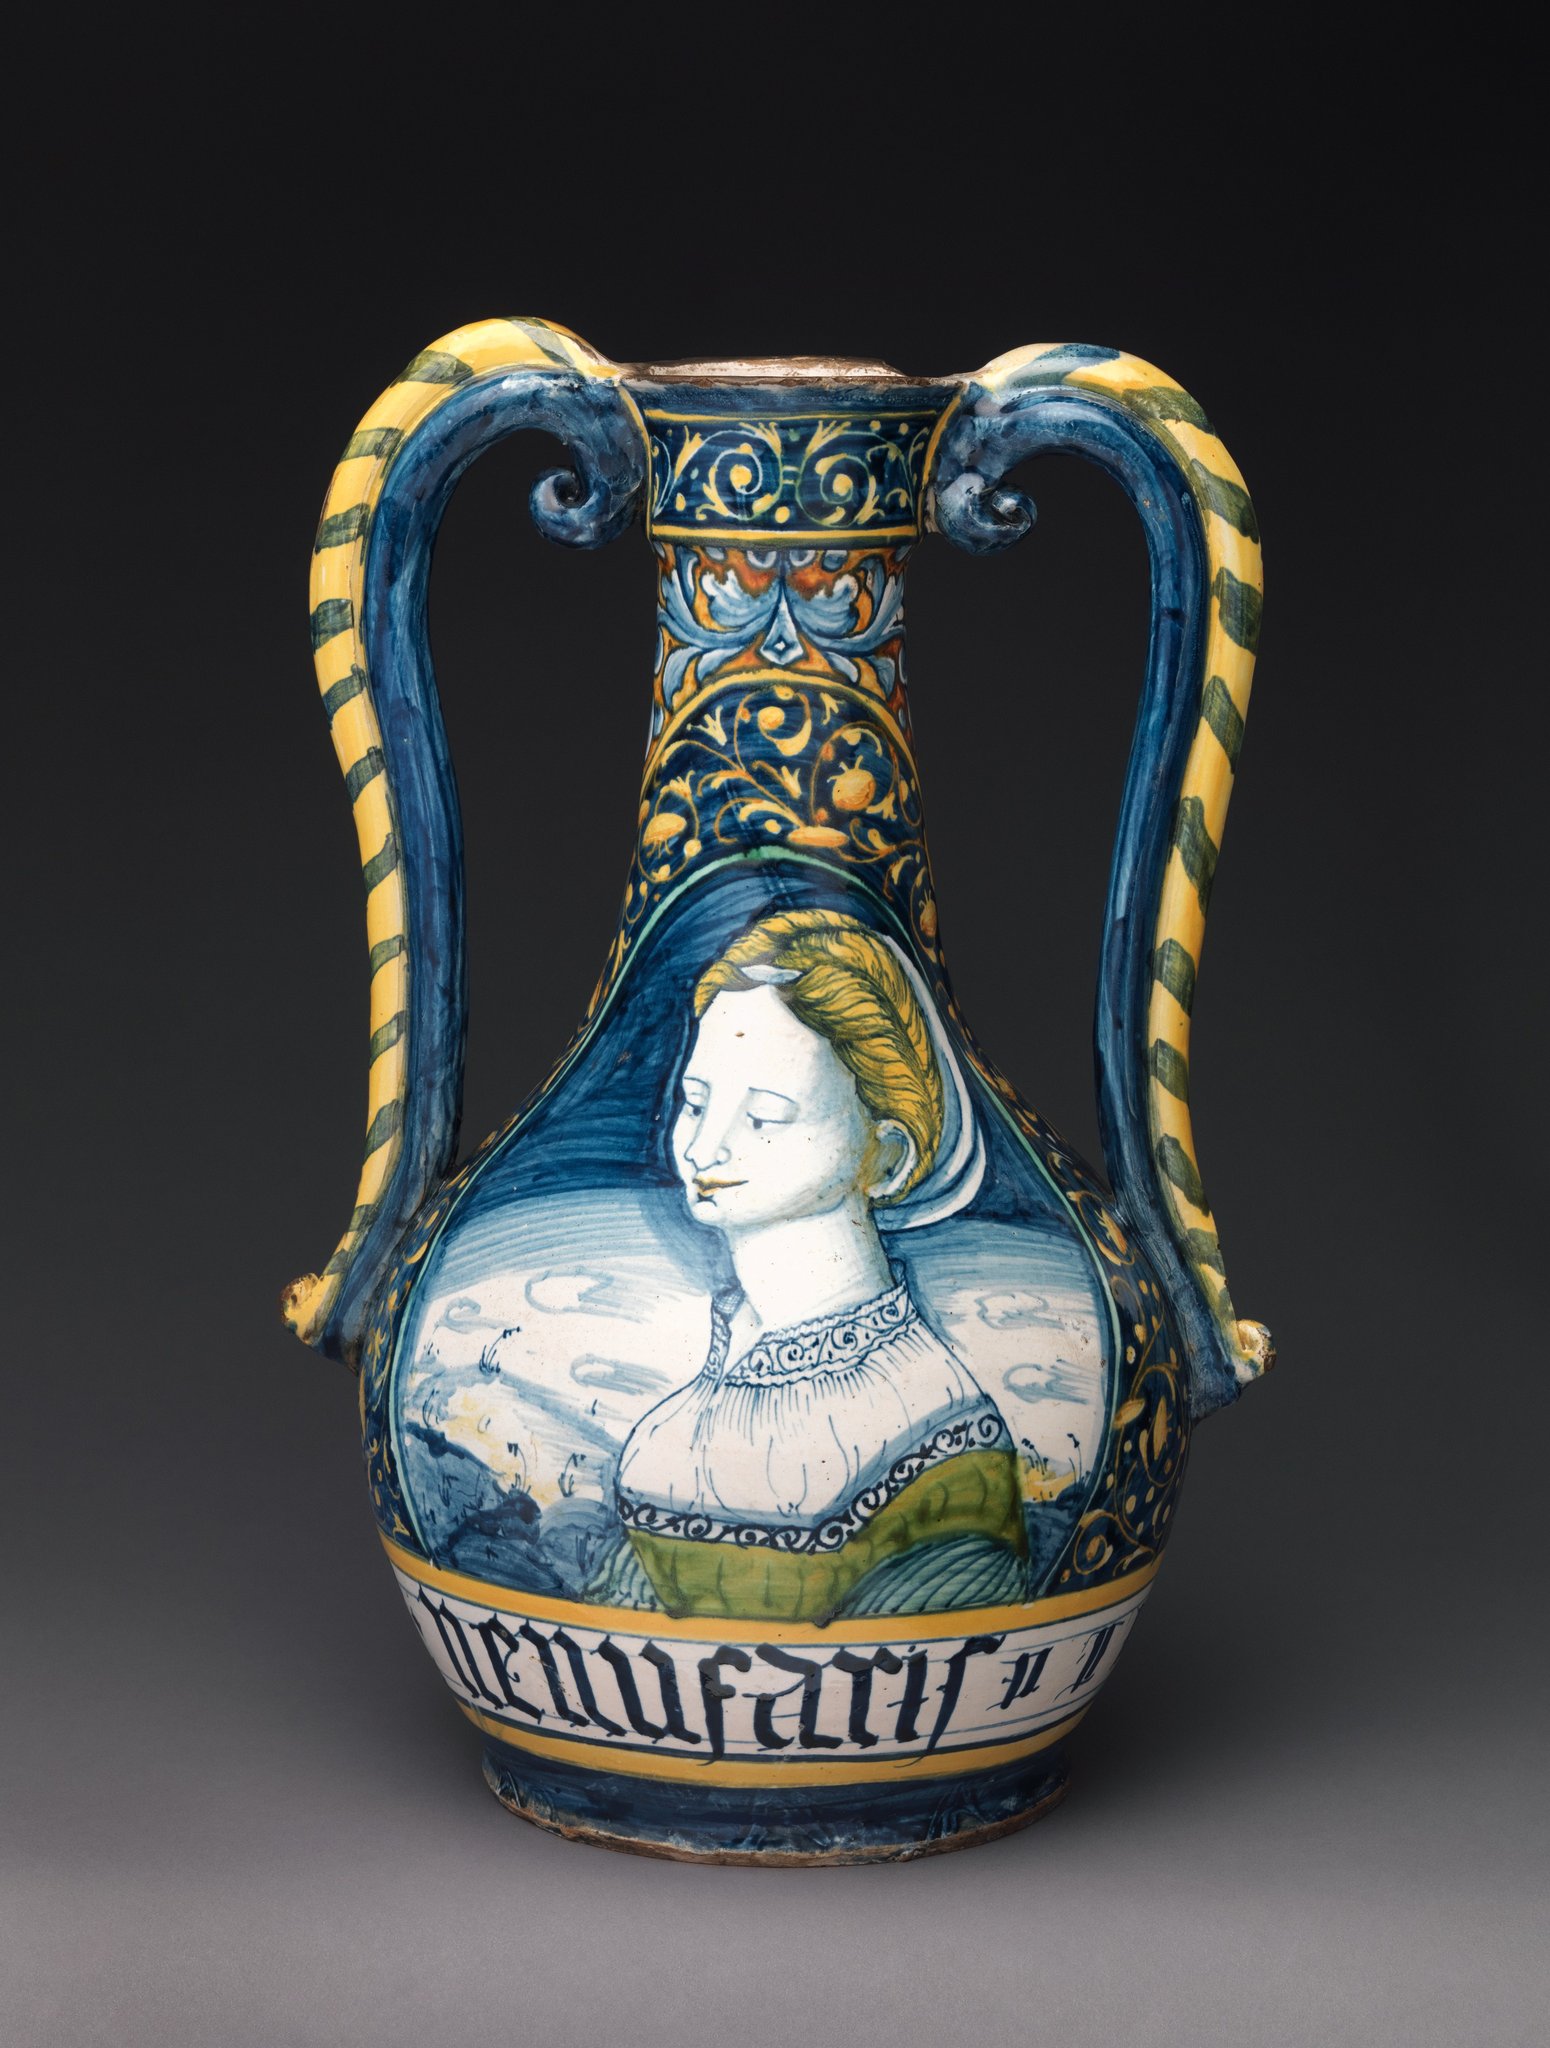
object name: pharmacy bottle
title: Pharmacy bottle (one of a pair)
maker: orazio pompei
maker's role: maker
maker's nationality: italian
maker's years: 1511-1596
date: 1550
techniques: maiolica, glazing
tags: women